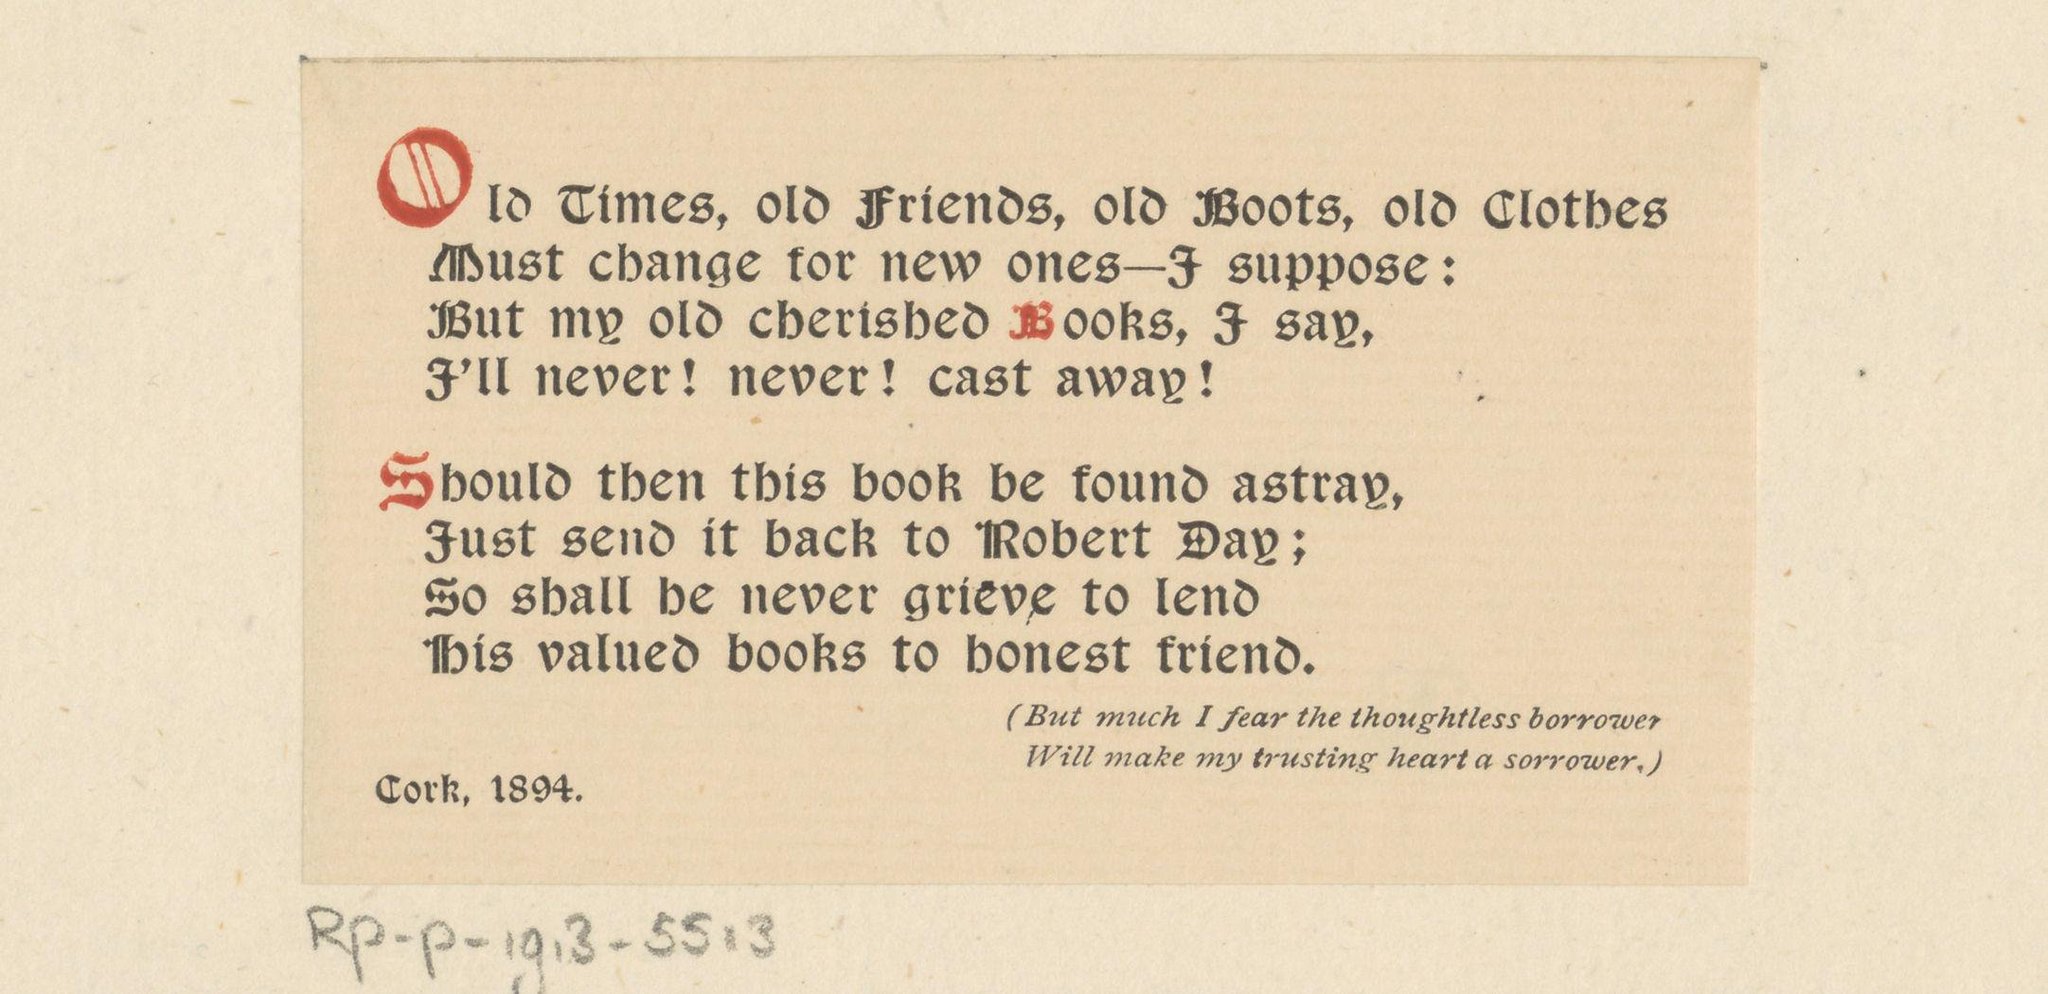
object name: bookplate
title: Ex libris van Robert Day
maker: Anonymous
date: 1894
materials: paper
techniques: letterpress printing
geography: cork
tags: robert day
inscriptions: collector's mark: Lugt 2233, collector's mark: Lugt 2760